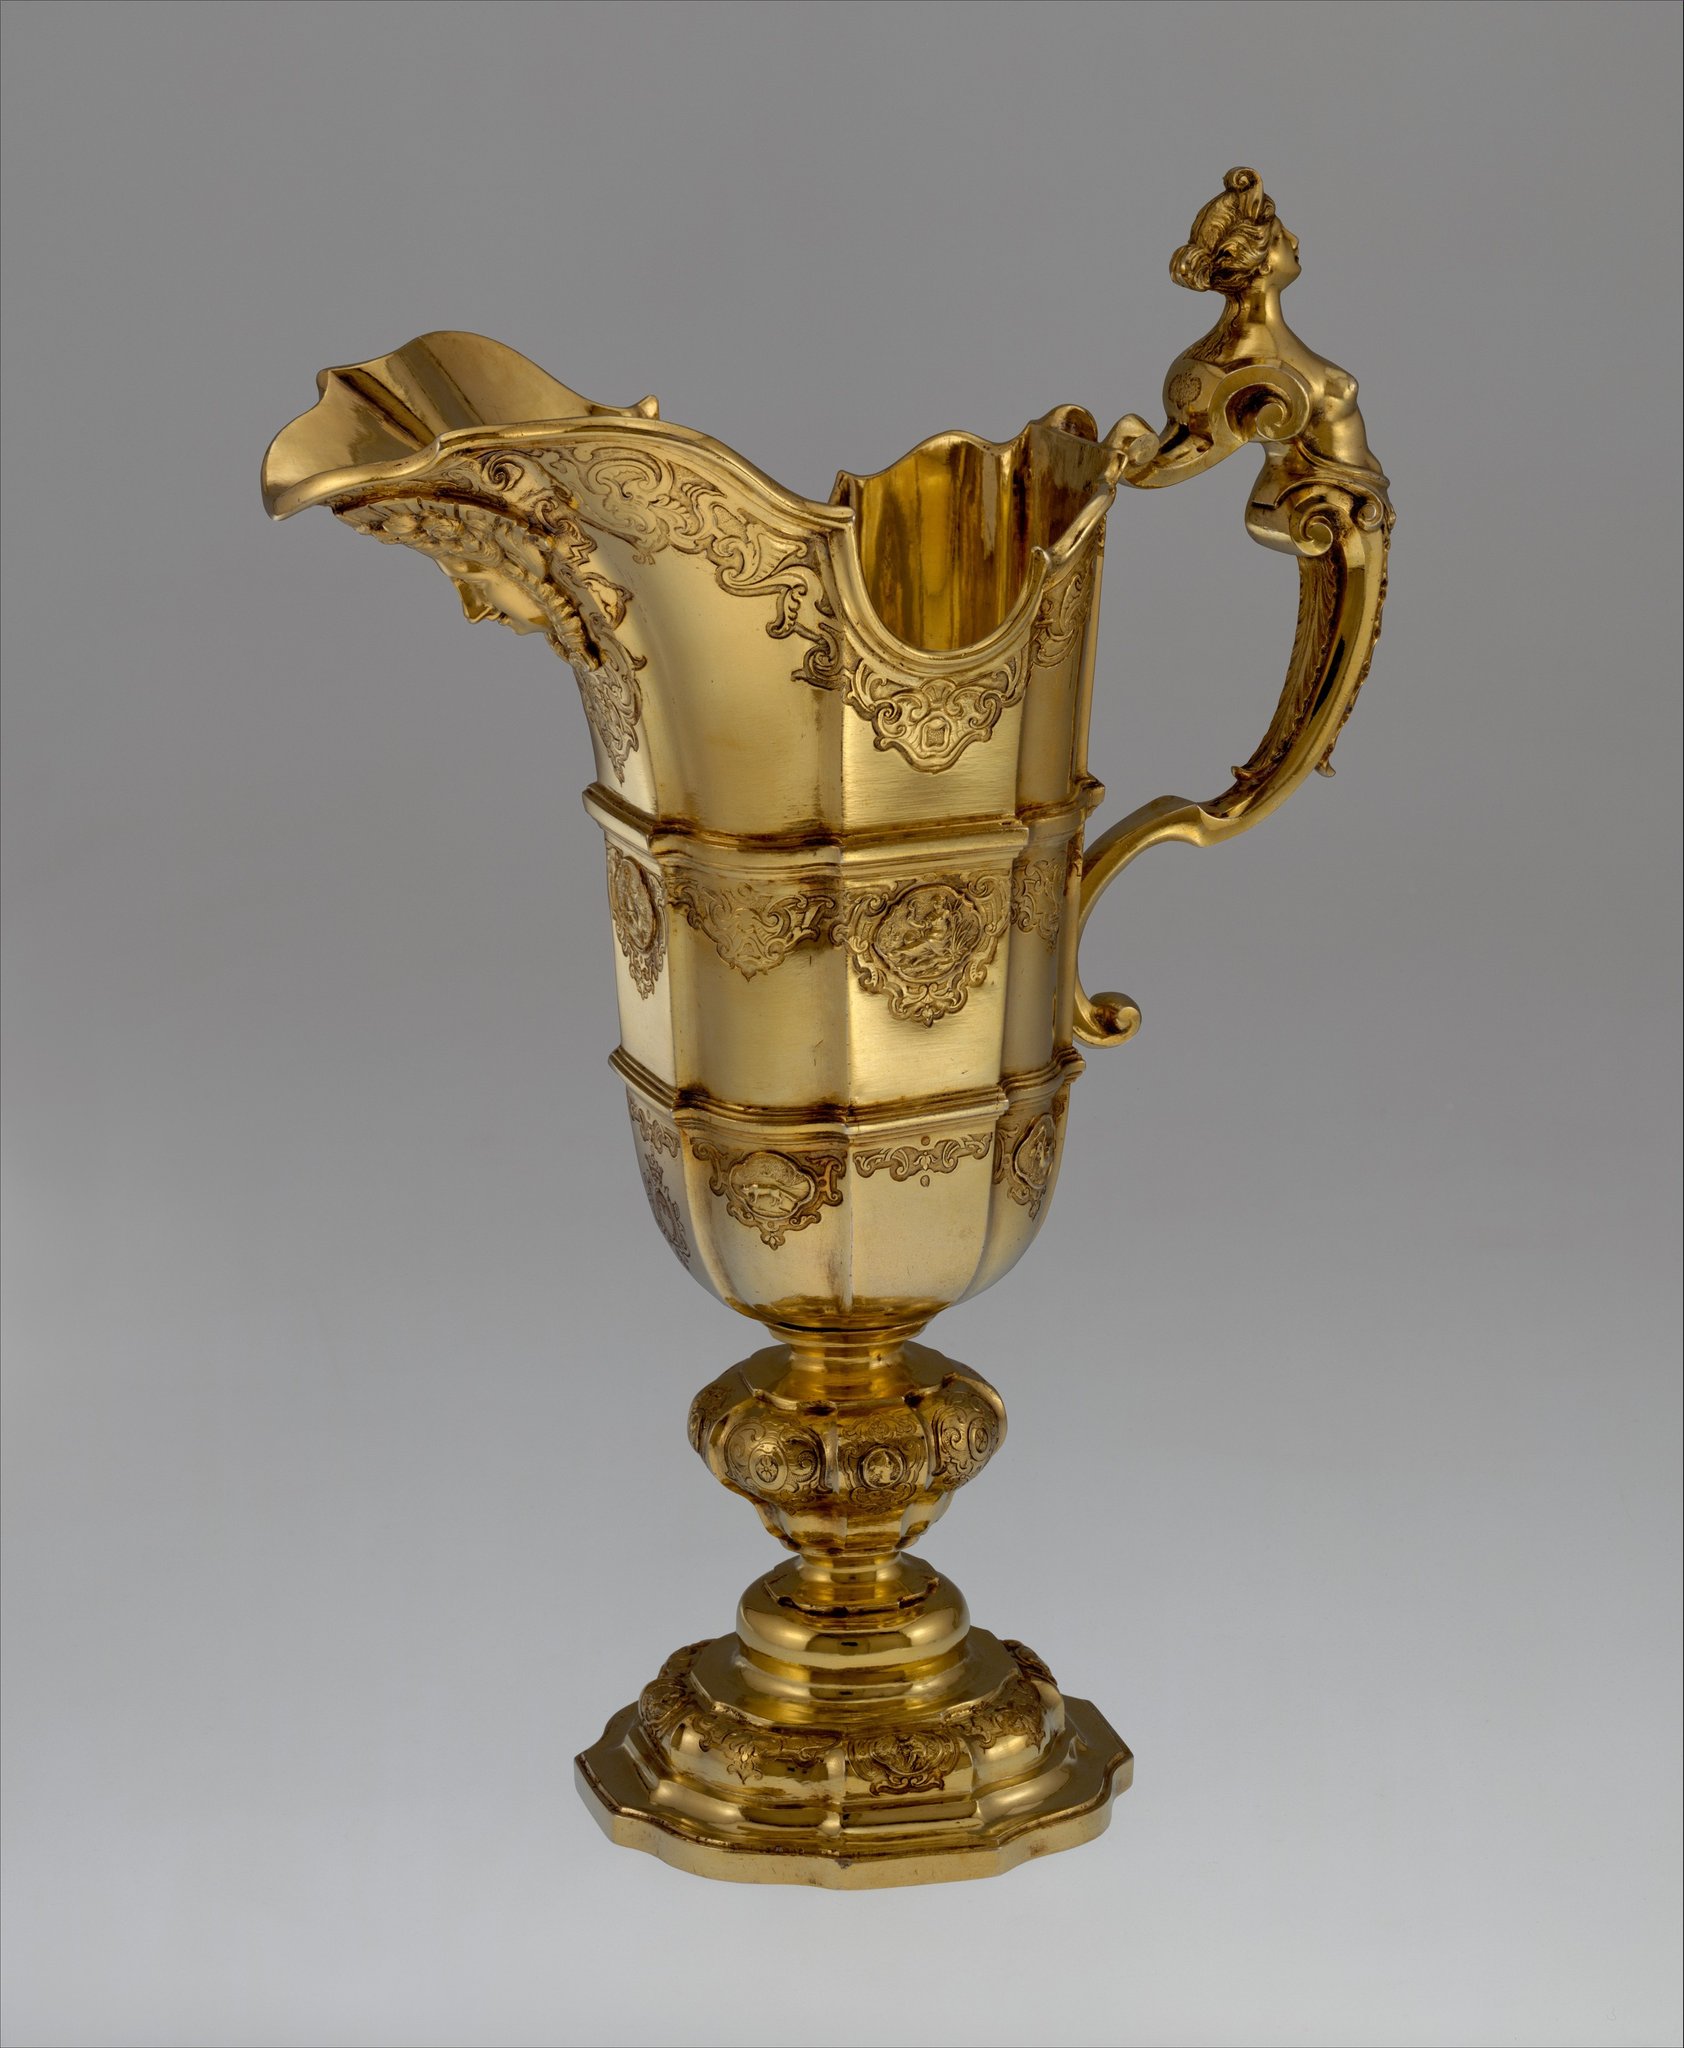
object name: rosewater ewer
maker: johann erhard heiglen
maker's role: maker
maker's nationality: german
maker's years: 1687-1757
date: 1730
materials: silver gilt